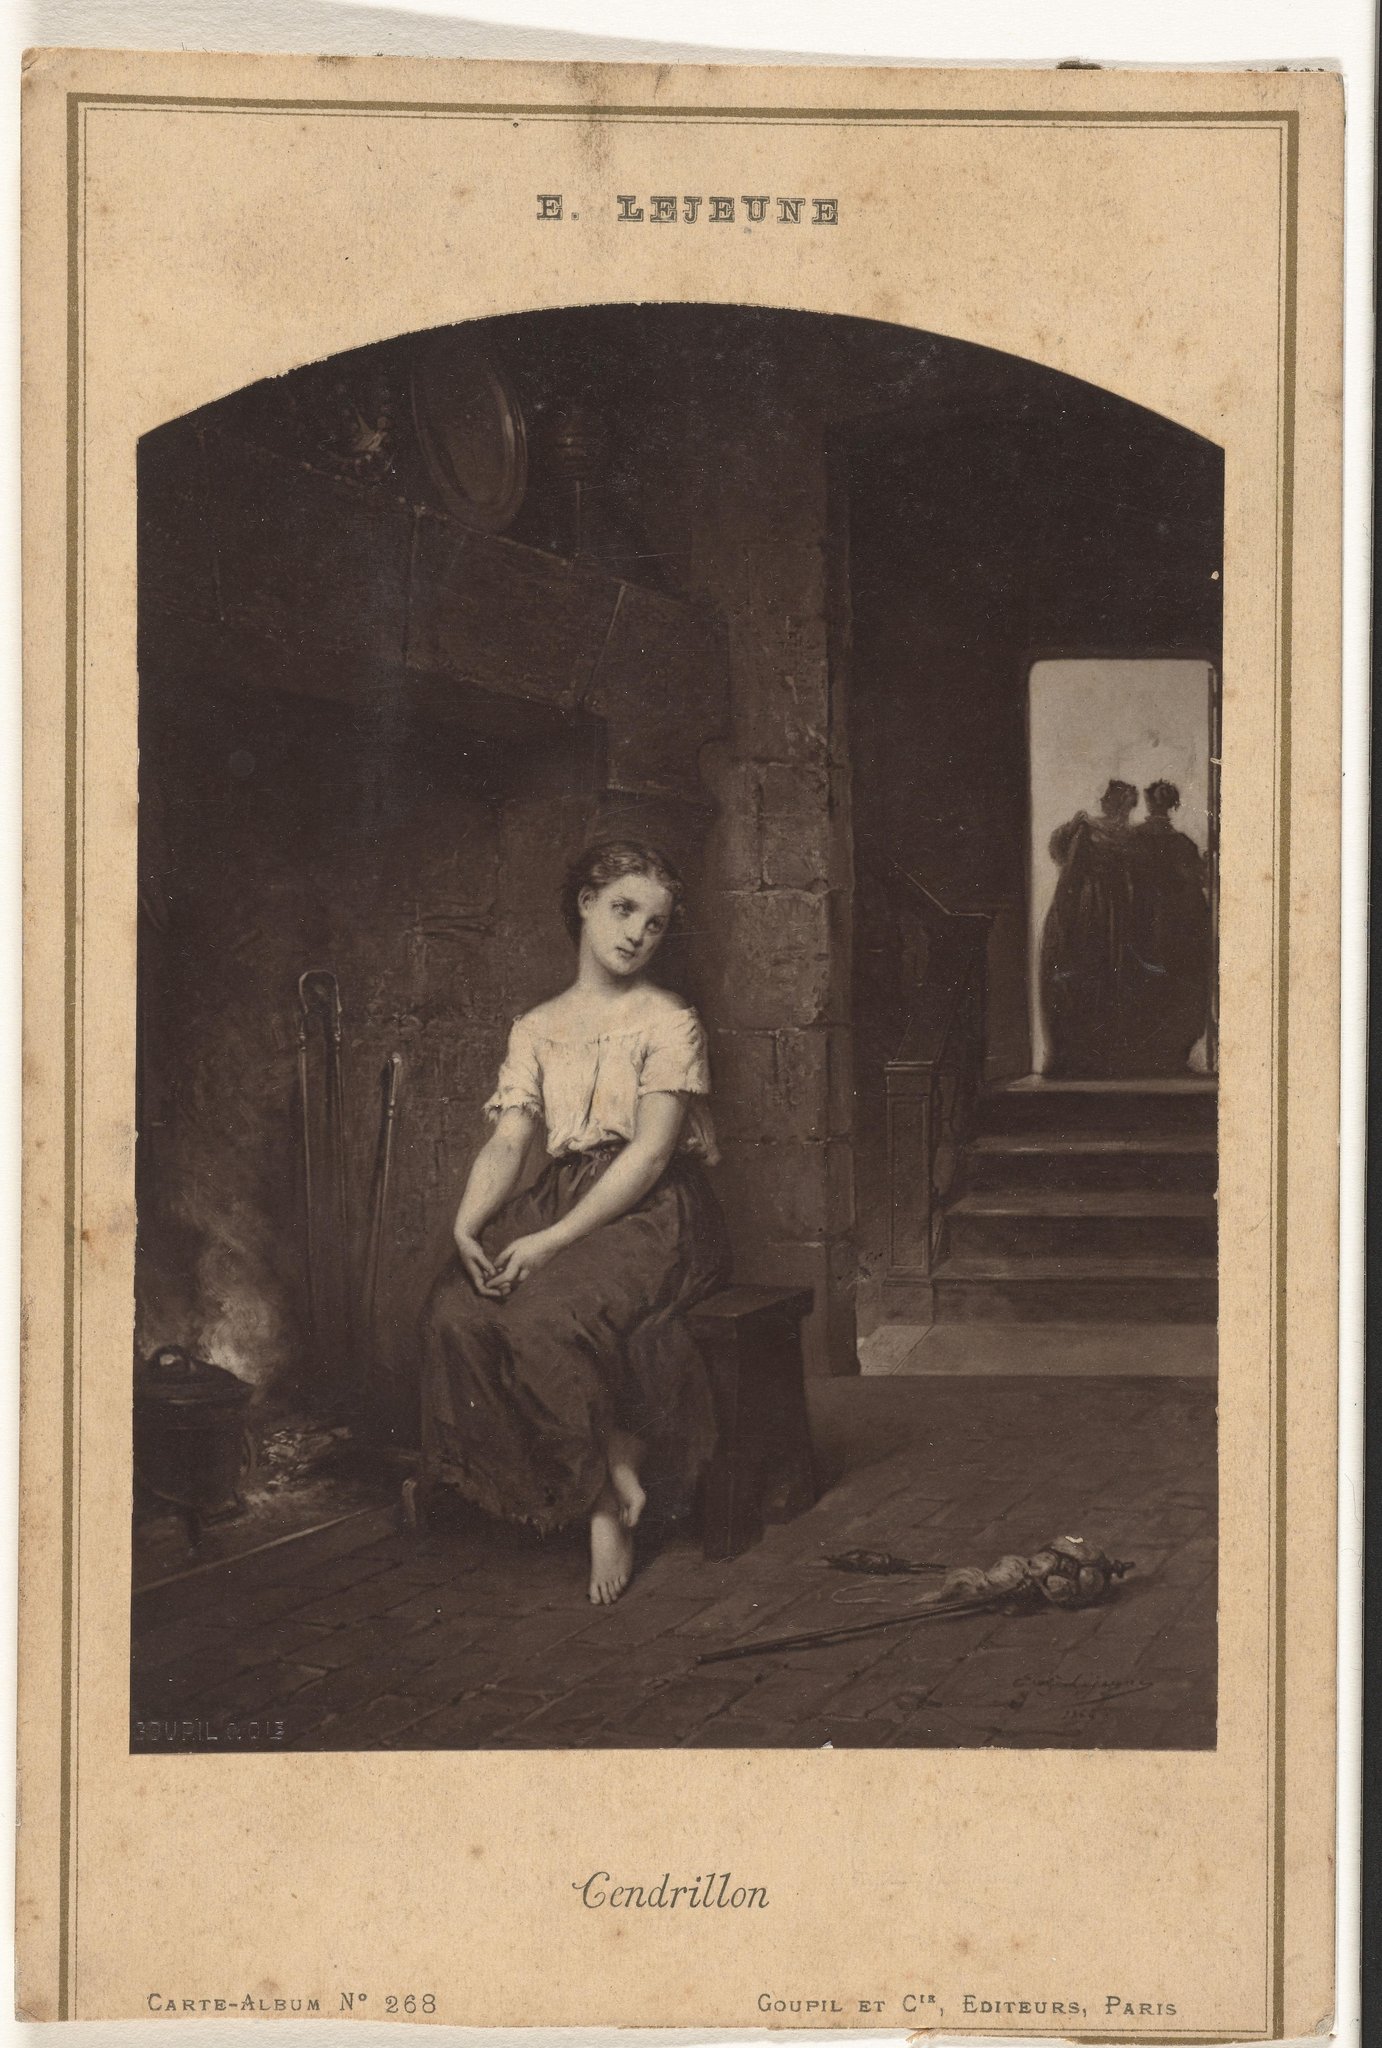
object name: reproduction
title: Cendrillon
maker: eugène joseph lejeune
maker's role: painter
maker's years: 1818-1897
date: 1866-1884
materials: cardboard, paper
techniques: albumen print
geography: paris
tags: tales and fairy tales (with title)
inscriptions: inscription: ‘Carte-Album No 268 Goupil & Cie, Editeurs, Paris’, collector's mark: ‘Vosmaer’, inscription: ‘E. Lejeune/ Cendrillon’, check stamp: ‘Goupil & Cie’